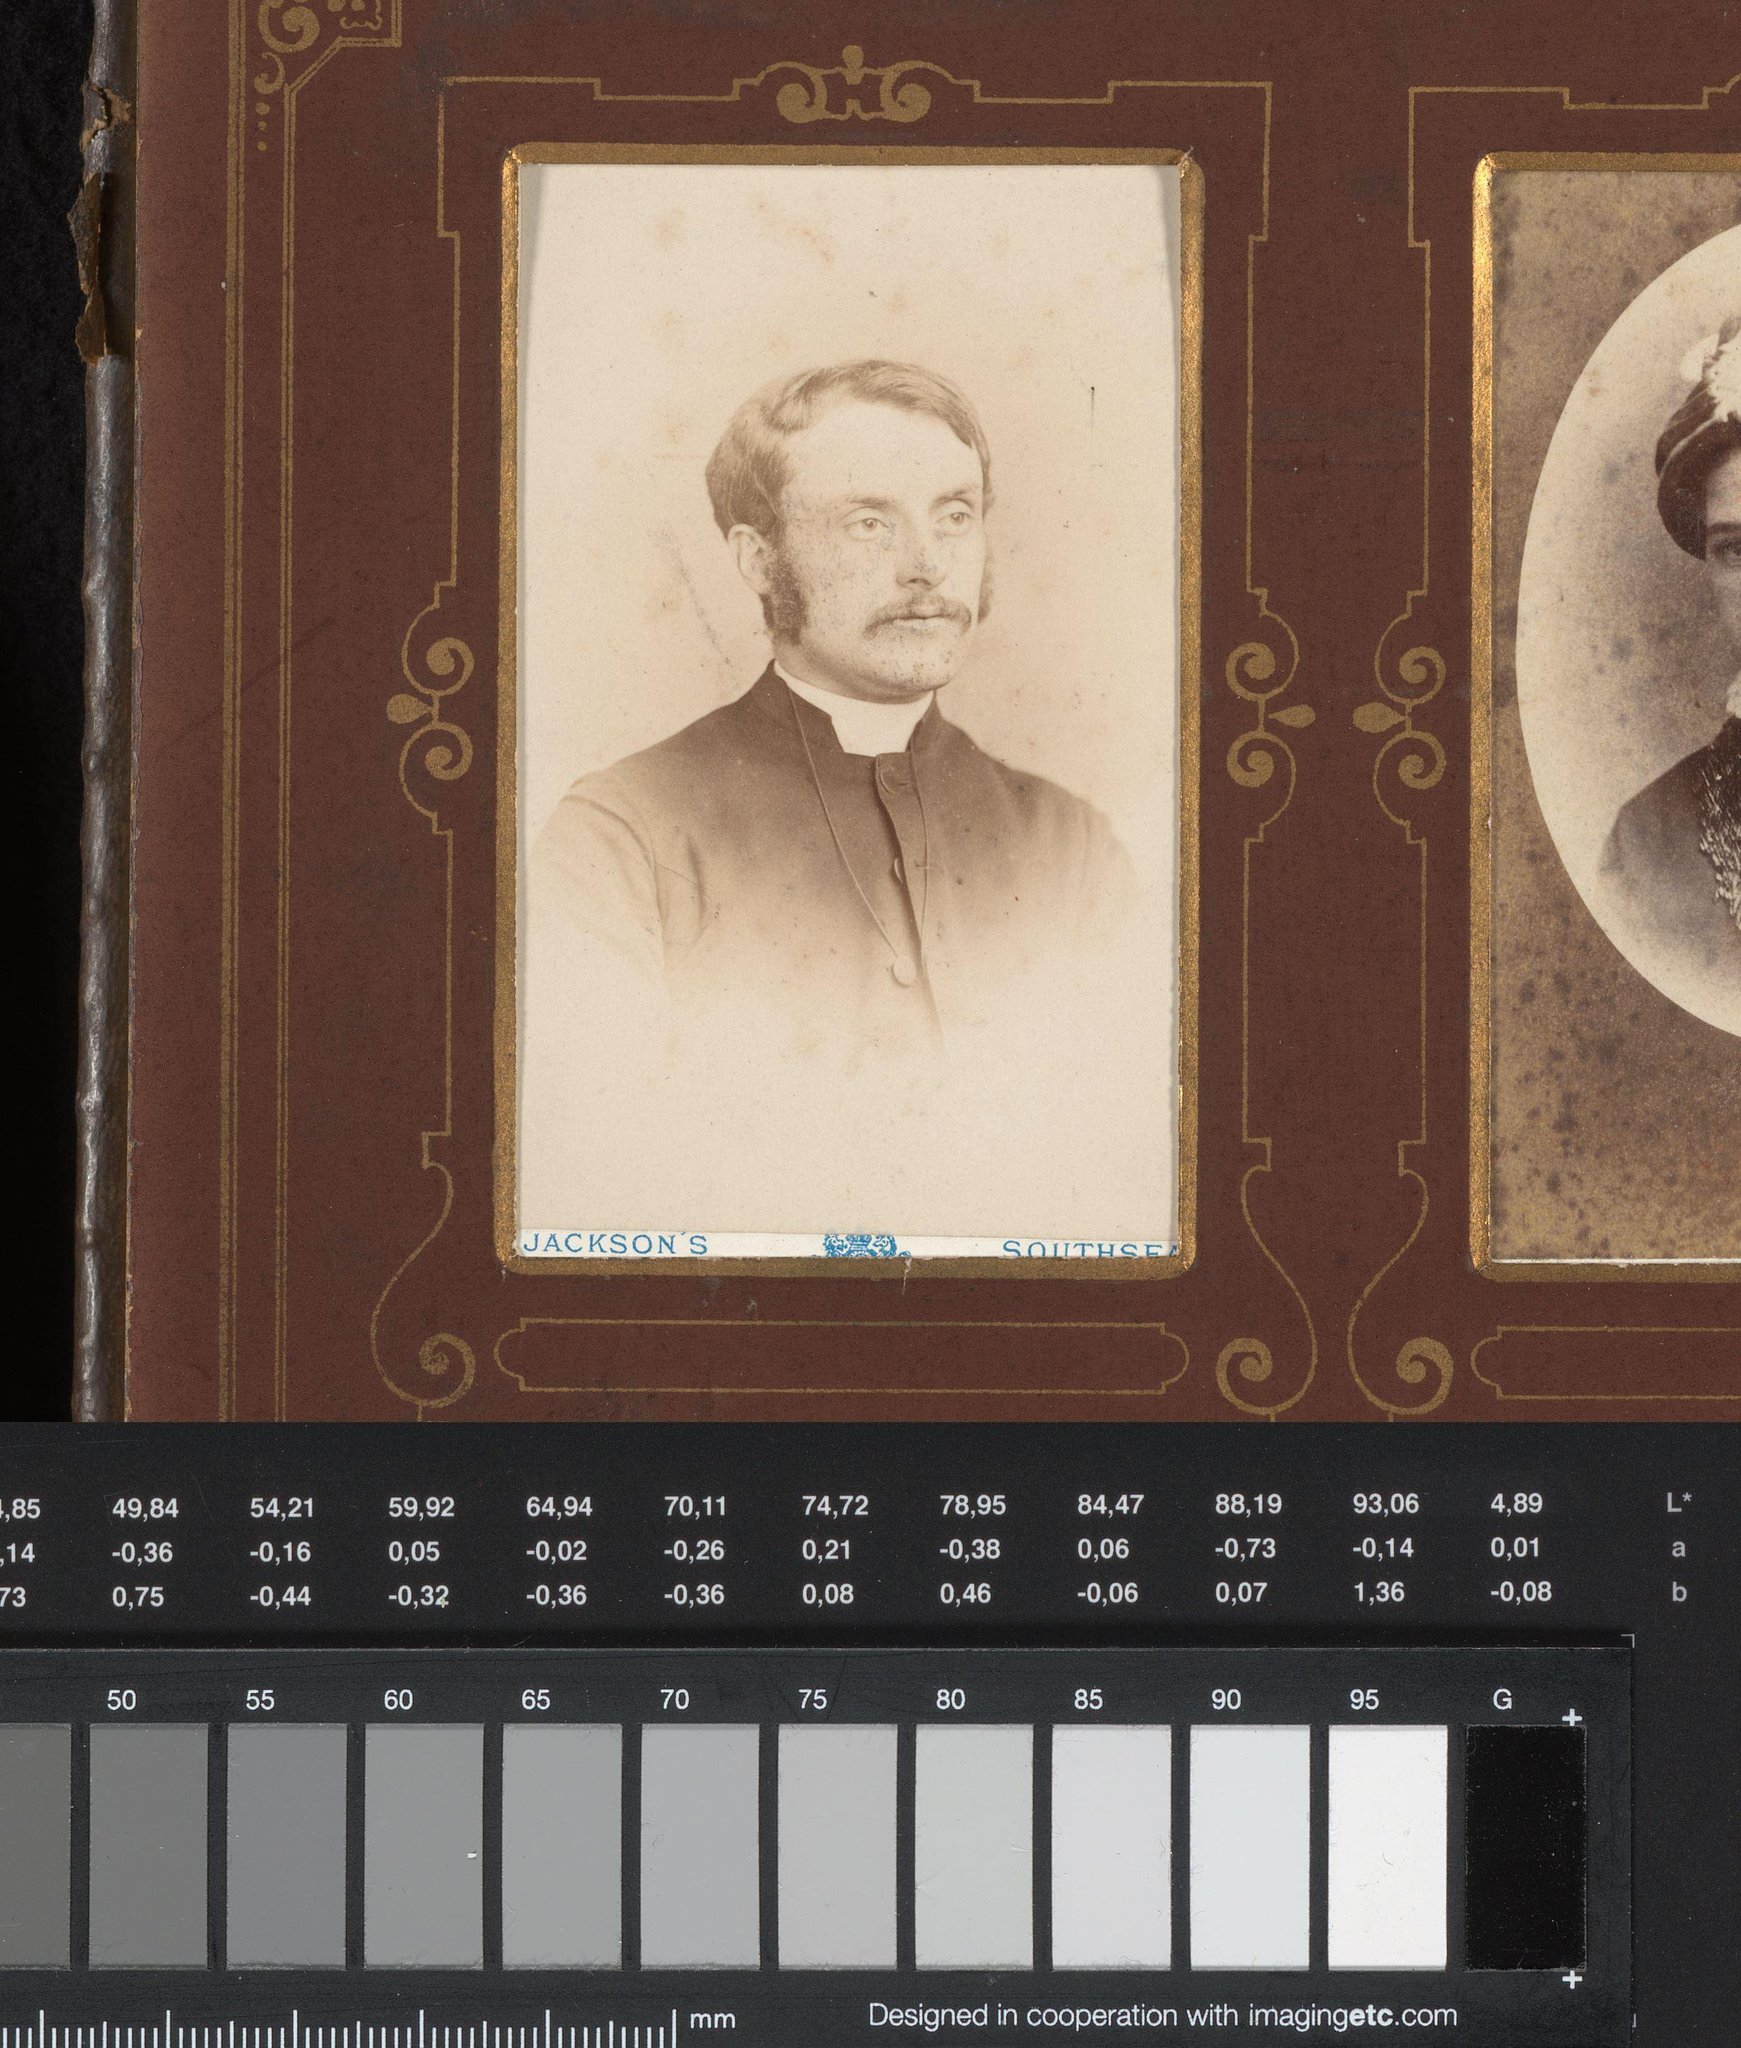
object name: photograph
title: Portret van een man met witte boord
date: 1860-1900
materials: cardboard, photographic support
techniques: albumen print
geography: southsea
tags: moustache, historical persons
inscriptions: inscription: ‘Fleming/ Late Jackson & Co./ photographer/ Royal/ Palmerston Road/ Southsea/ Hants’